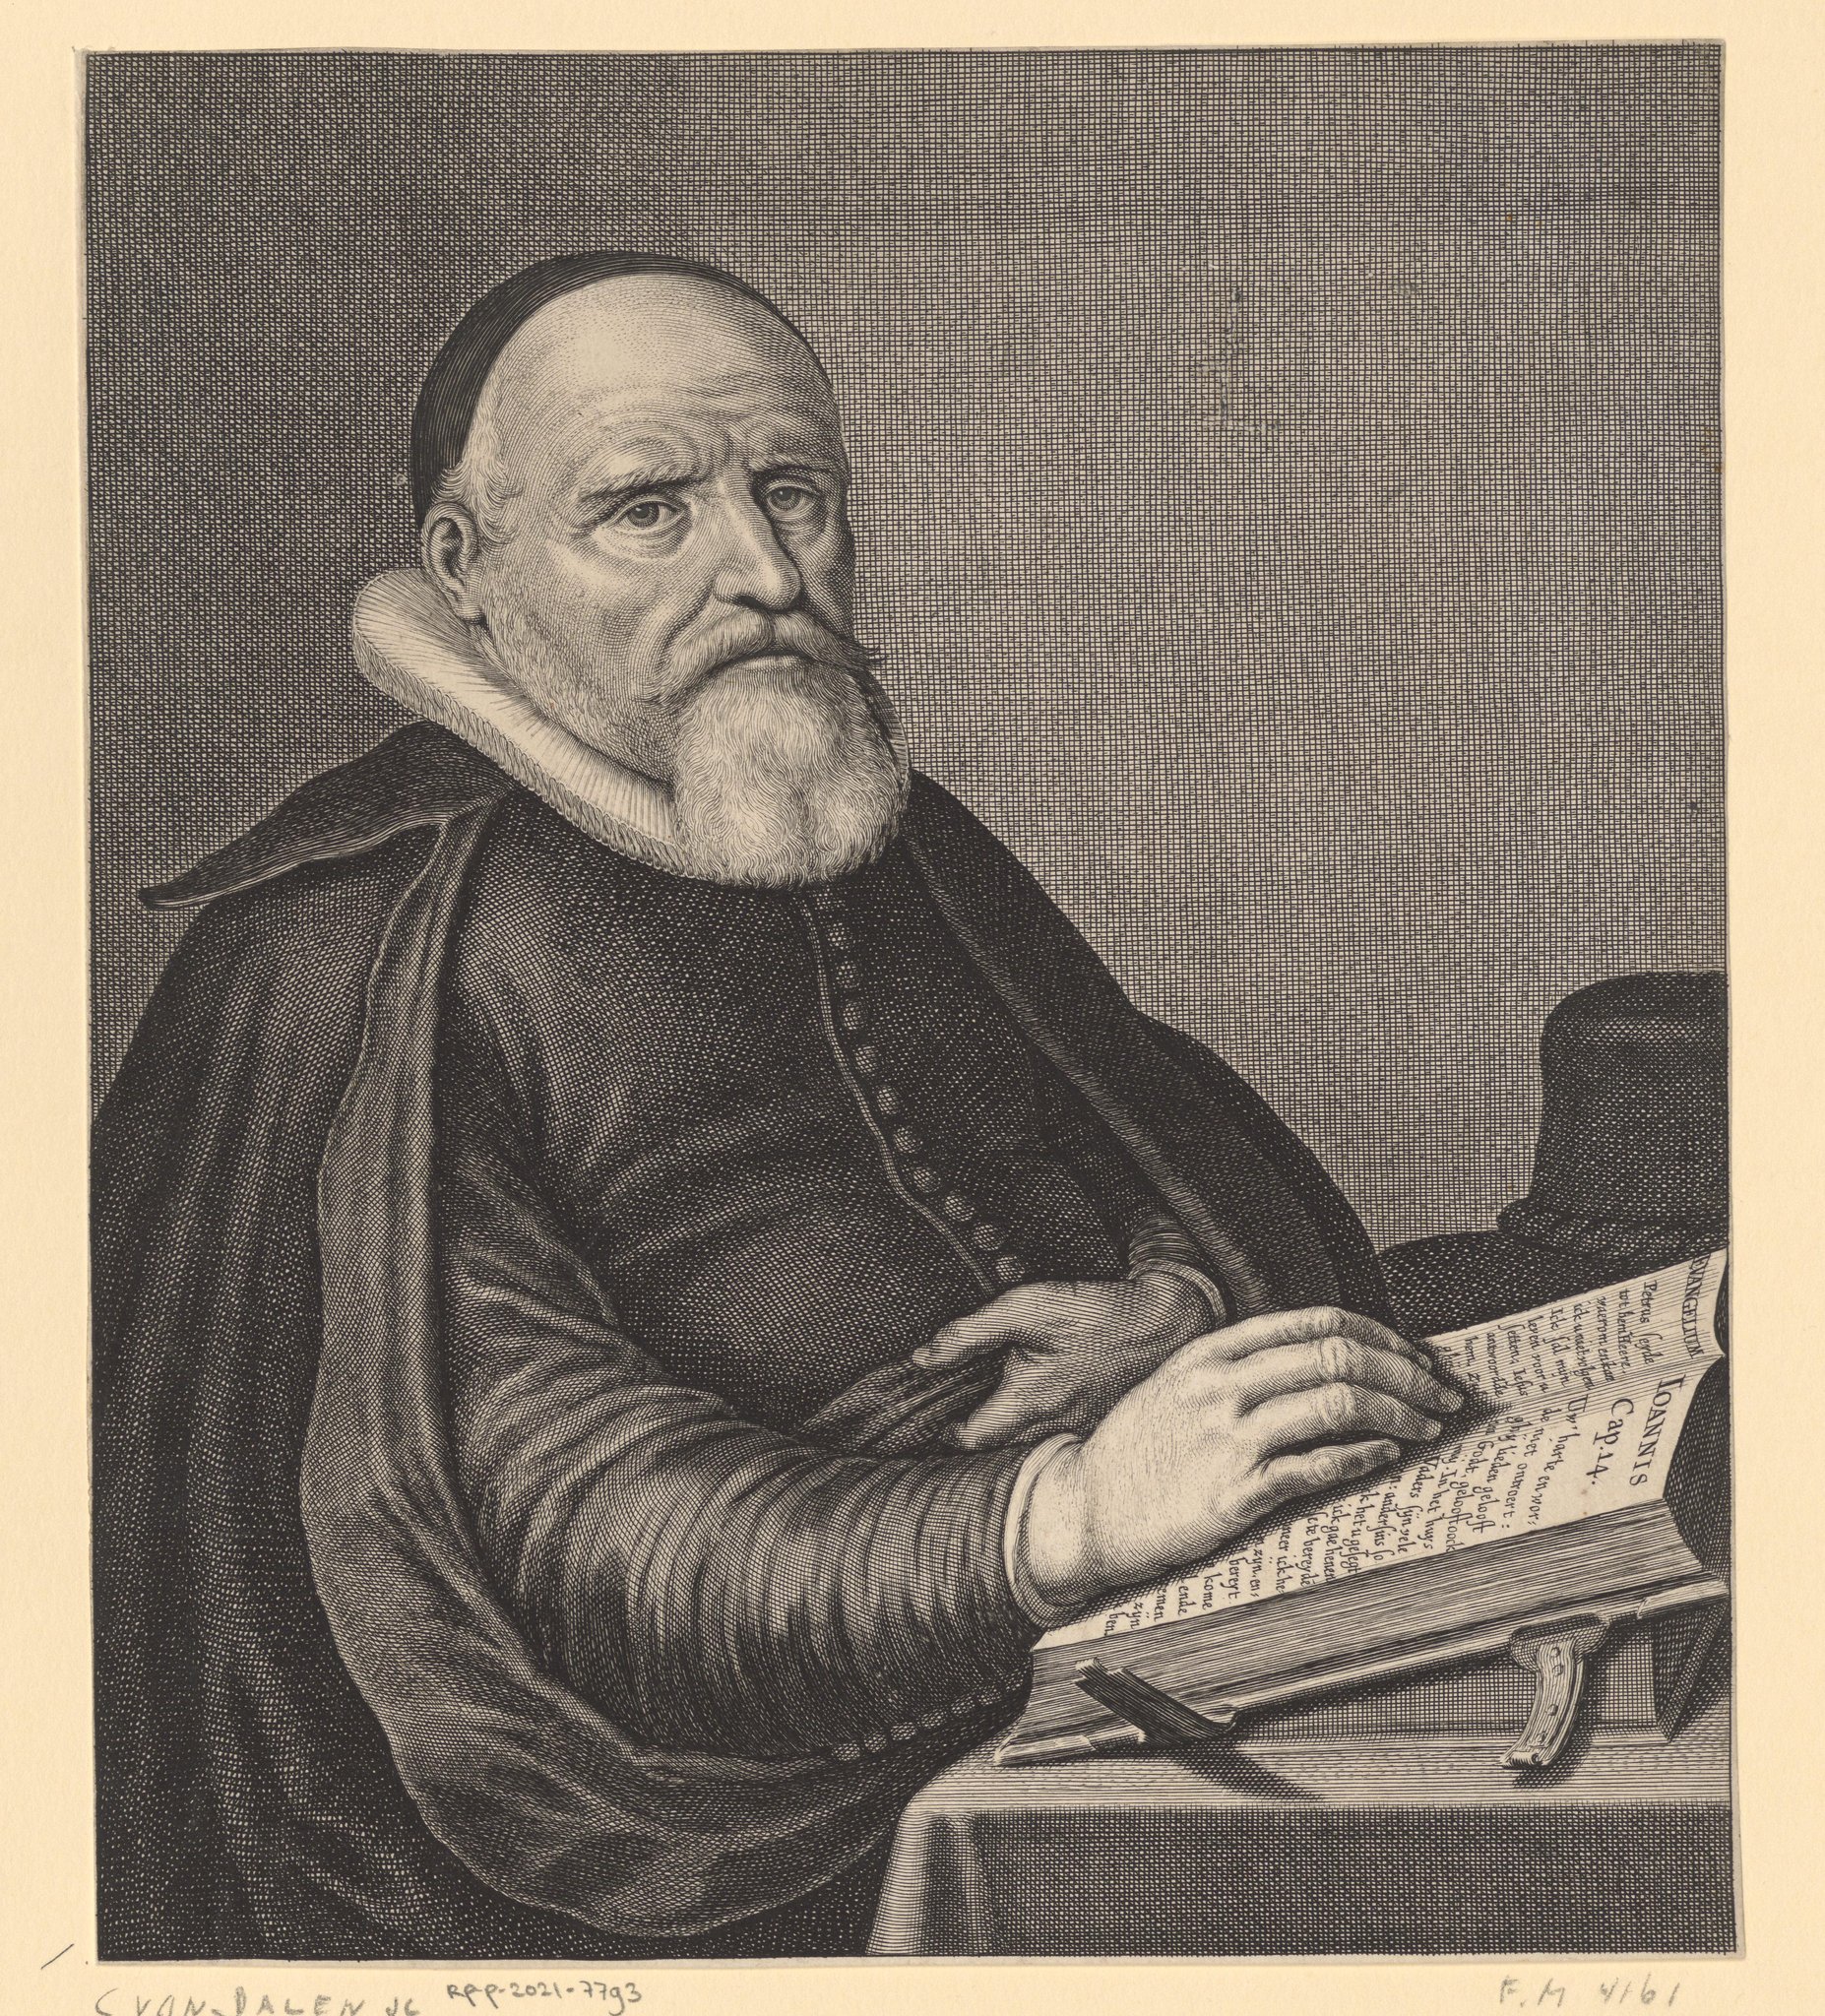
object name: print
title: Portret van Rudolphus Petri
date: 1649-1665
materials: paper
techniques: engraving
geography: amsterdam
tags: historical persons, book - mm - book open